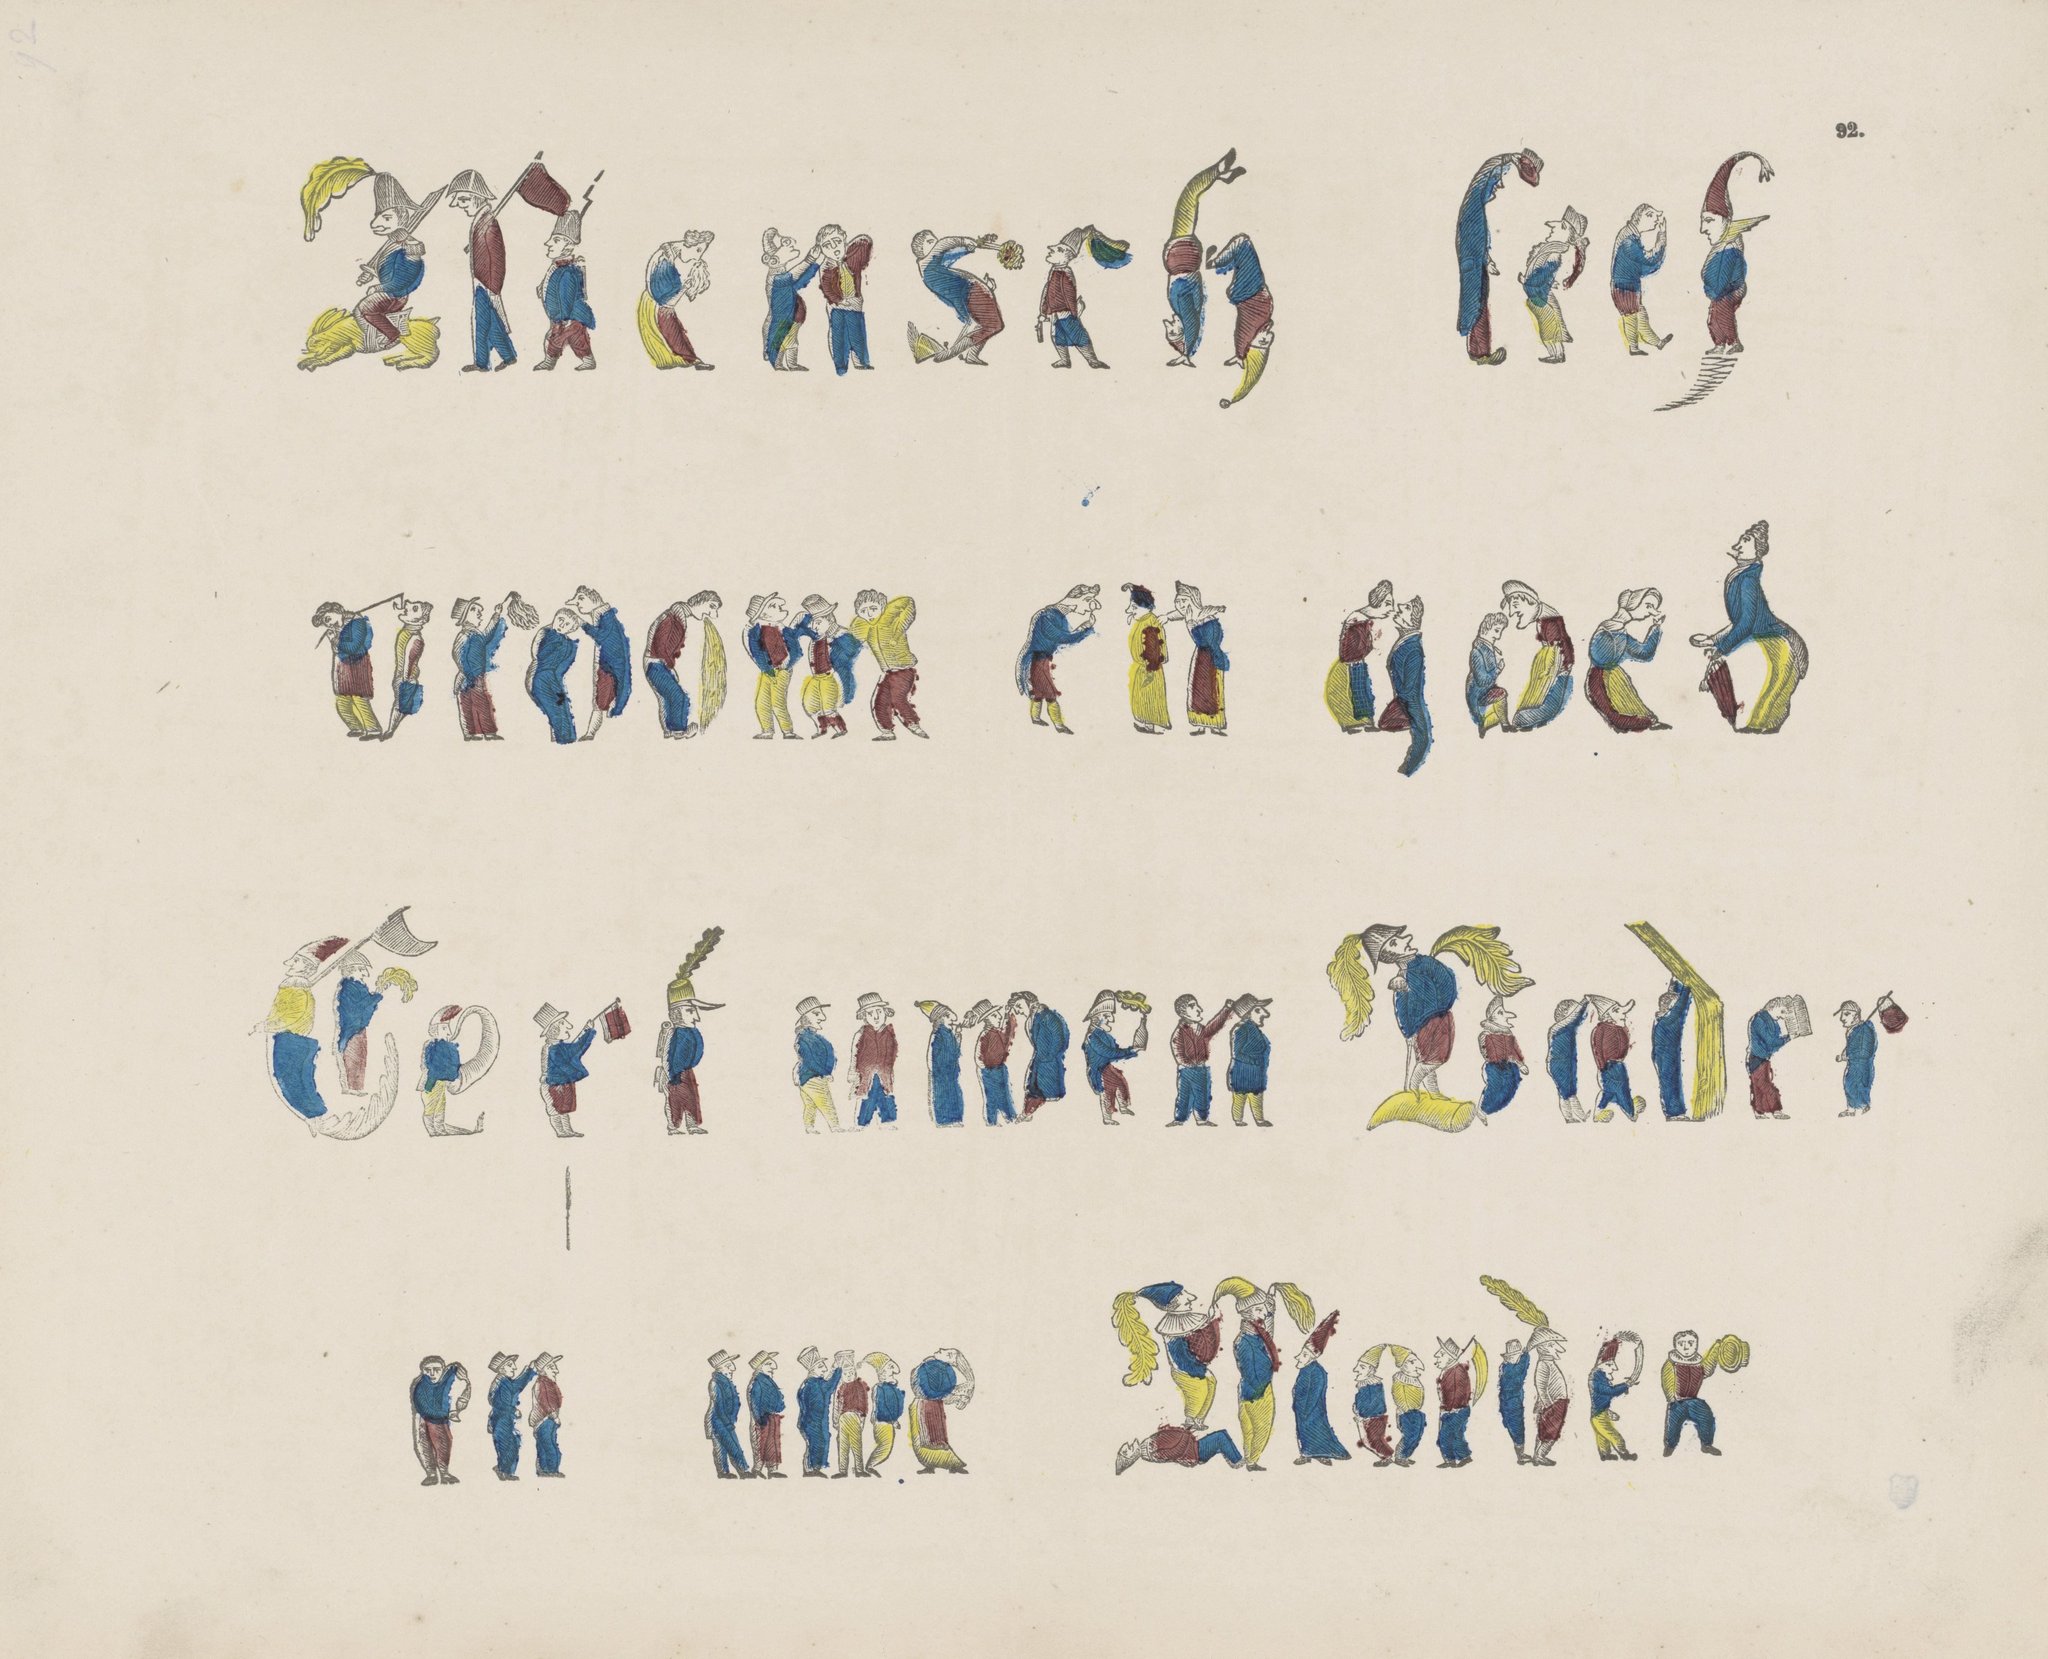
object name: print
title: Mensch leef vroom en goed eert uwen vader en uw moeder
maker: Anonymous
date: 1848-1881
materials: paper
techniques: colour, letterpress printing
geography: netherlands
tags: letters, alphabet, script, fancy letters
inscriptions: collector's mark: Lugt 2760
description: De tekst 'Mensch leef vroom en goed eert uwen vader en uw moeder' in sierletters bestaande uit menselijke figuren die spreekwoorden verbeelden. Genummerd rechtsboven: 92.